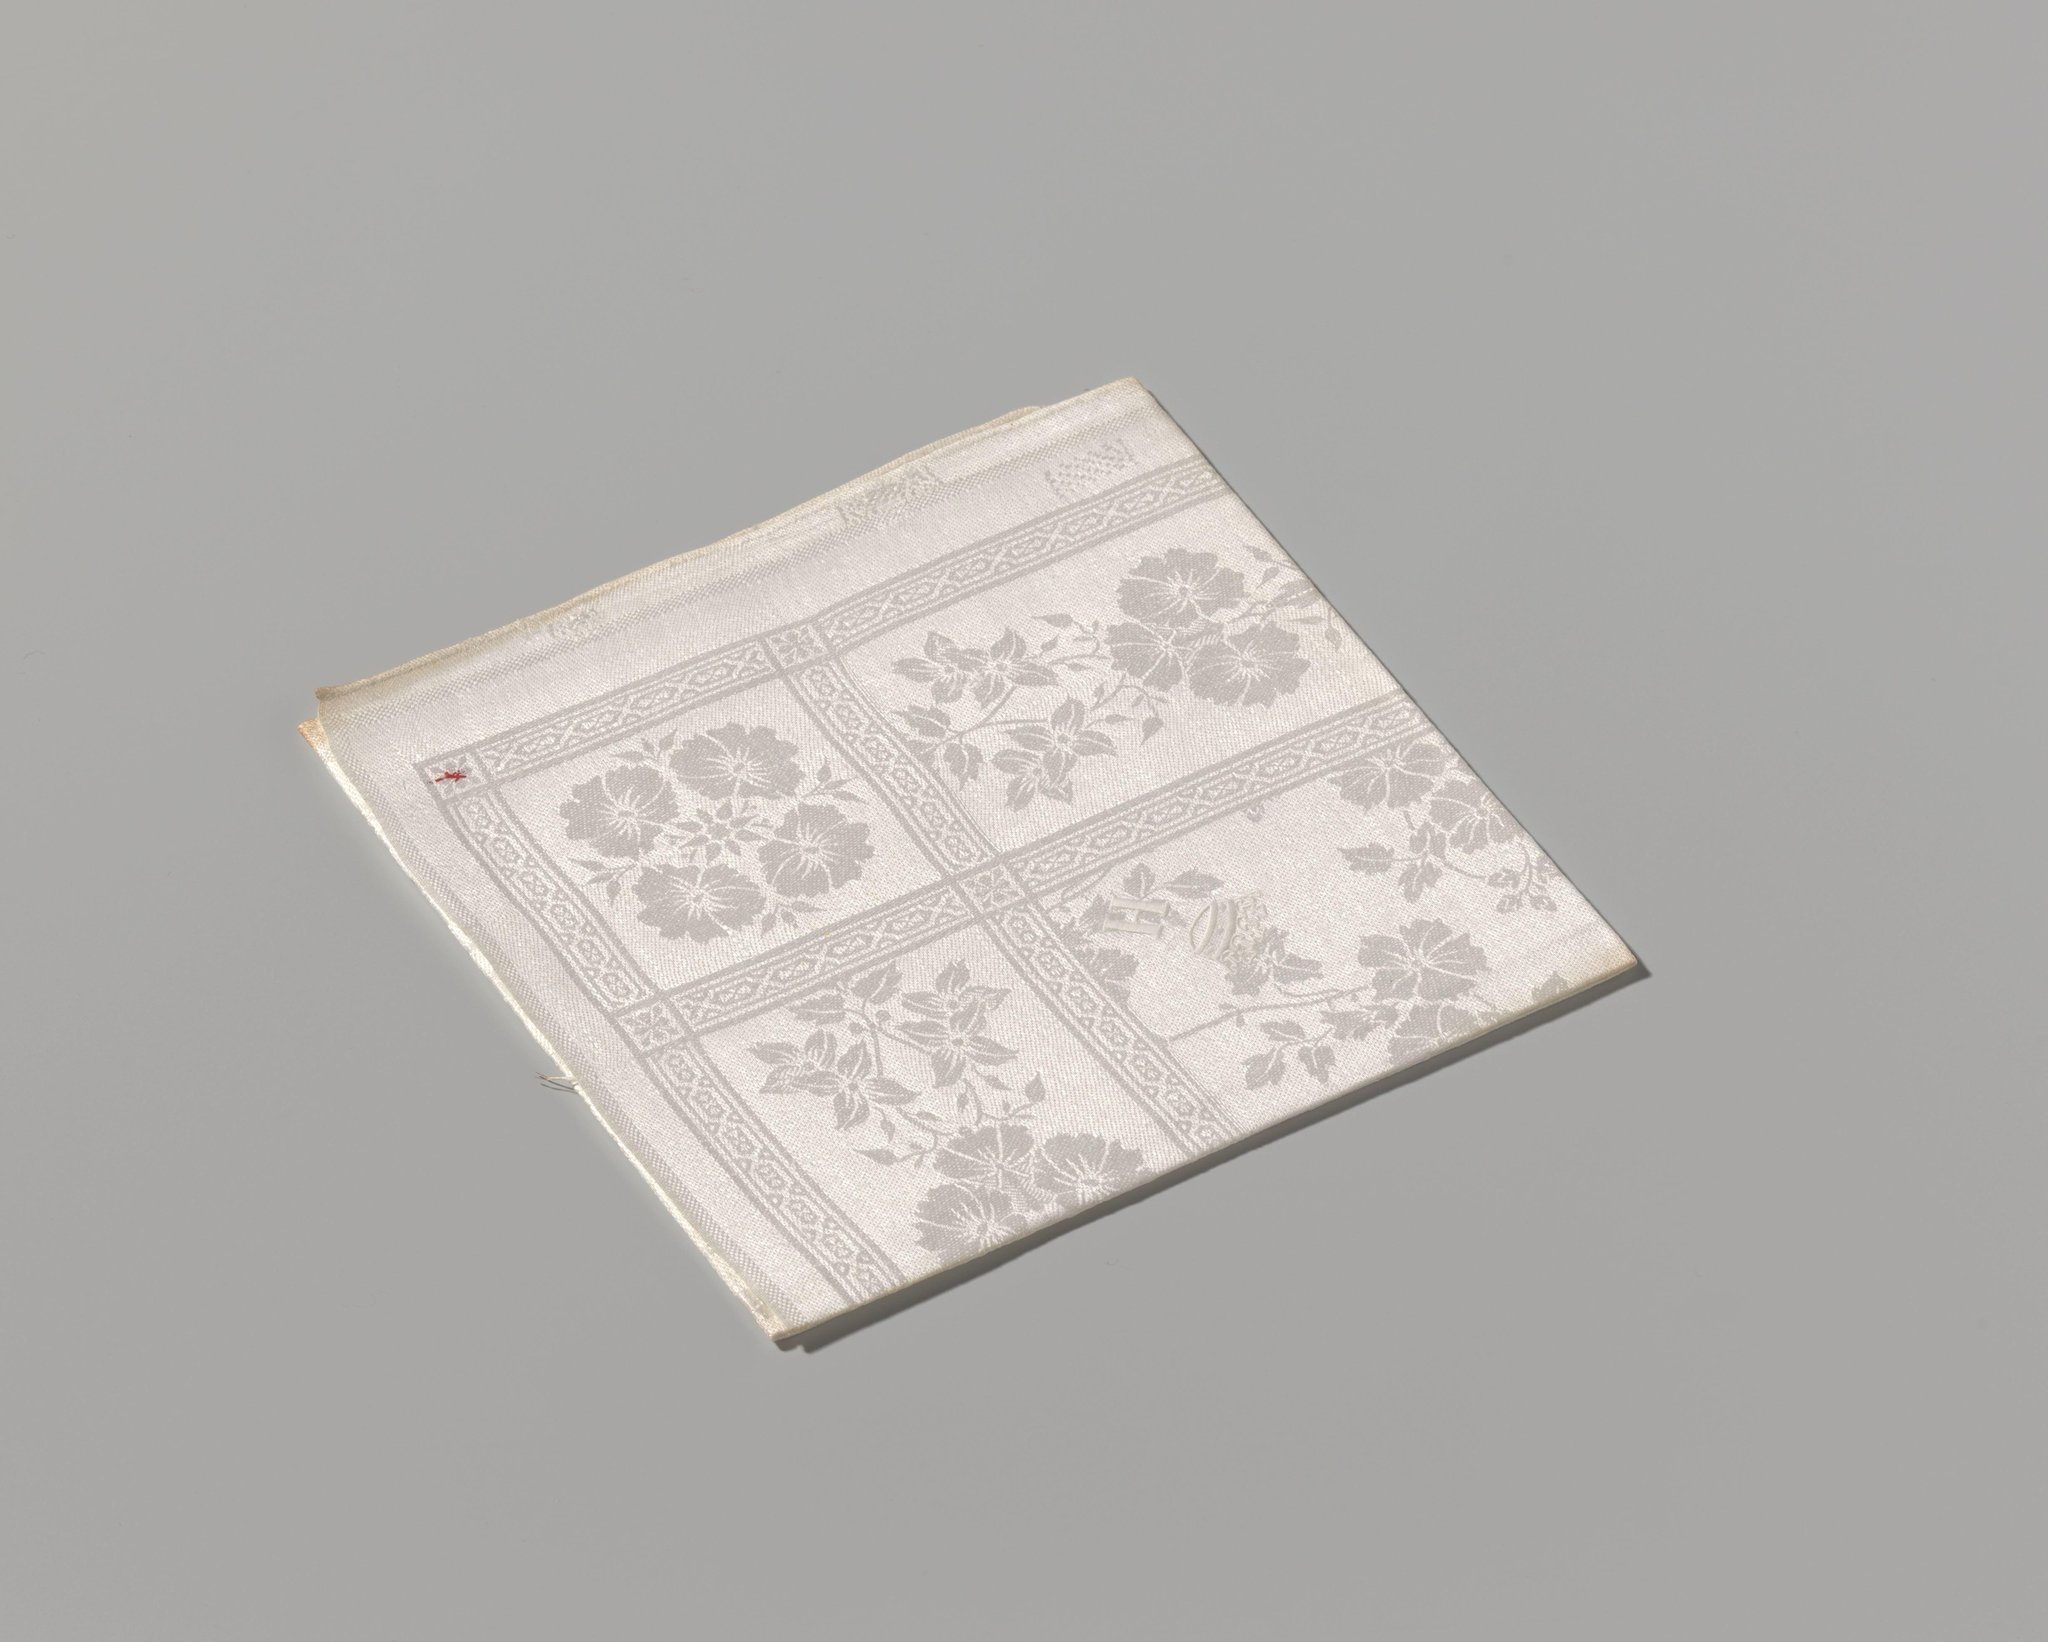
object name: napkin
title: Servet van wit linnendamast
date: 1859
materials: linen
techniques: damask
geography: borne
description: Wit linnen damasten servet met "convolvulos", merk kroon H.